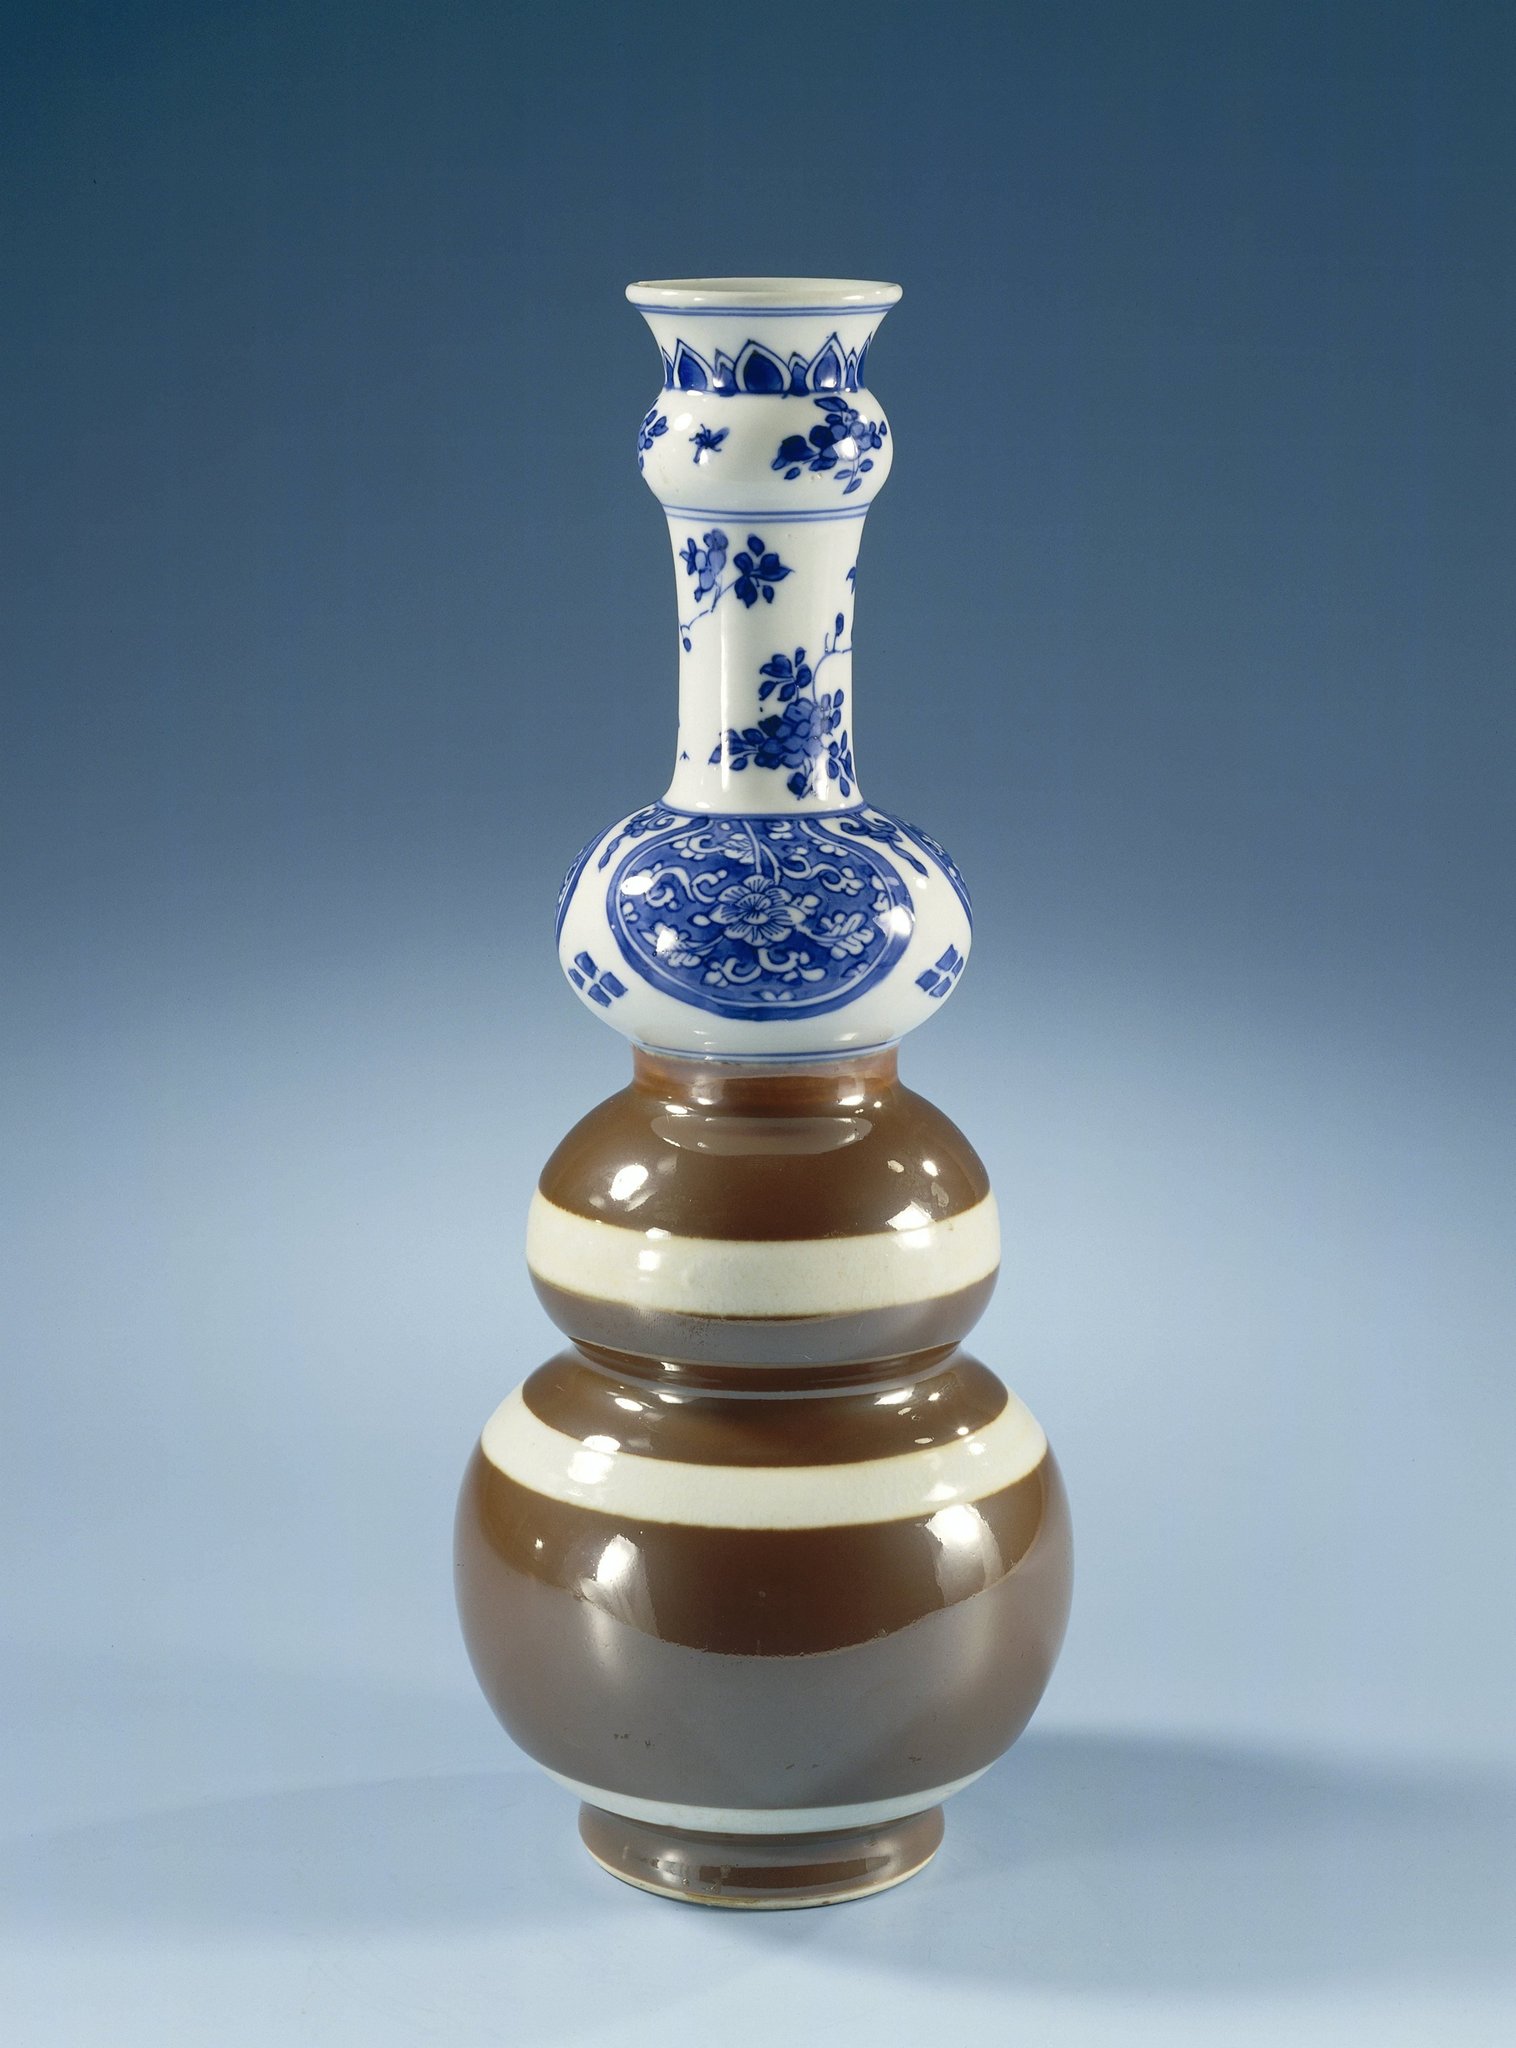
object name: knobbelfles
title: Triple gourd-shaped bottle with brown glaze and flower scrolls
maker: Anonymous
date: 1675-1699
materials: cobalt, glaze, paint, porcelain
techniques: firing, turning, vitrification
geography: china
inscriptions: label: ‘Vrienden der Aziatische Kunst’